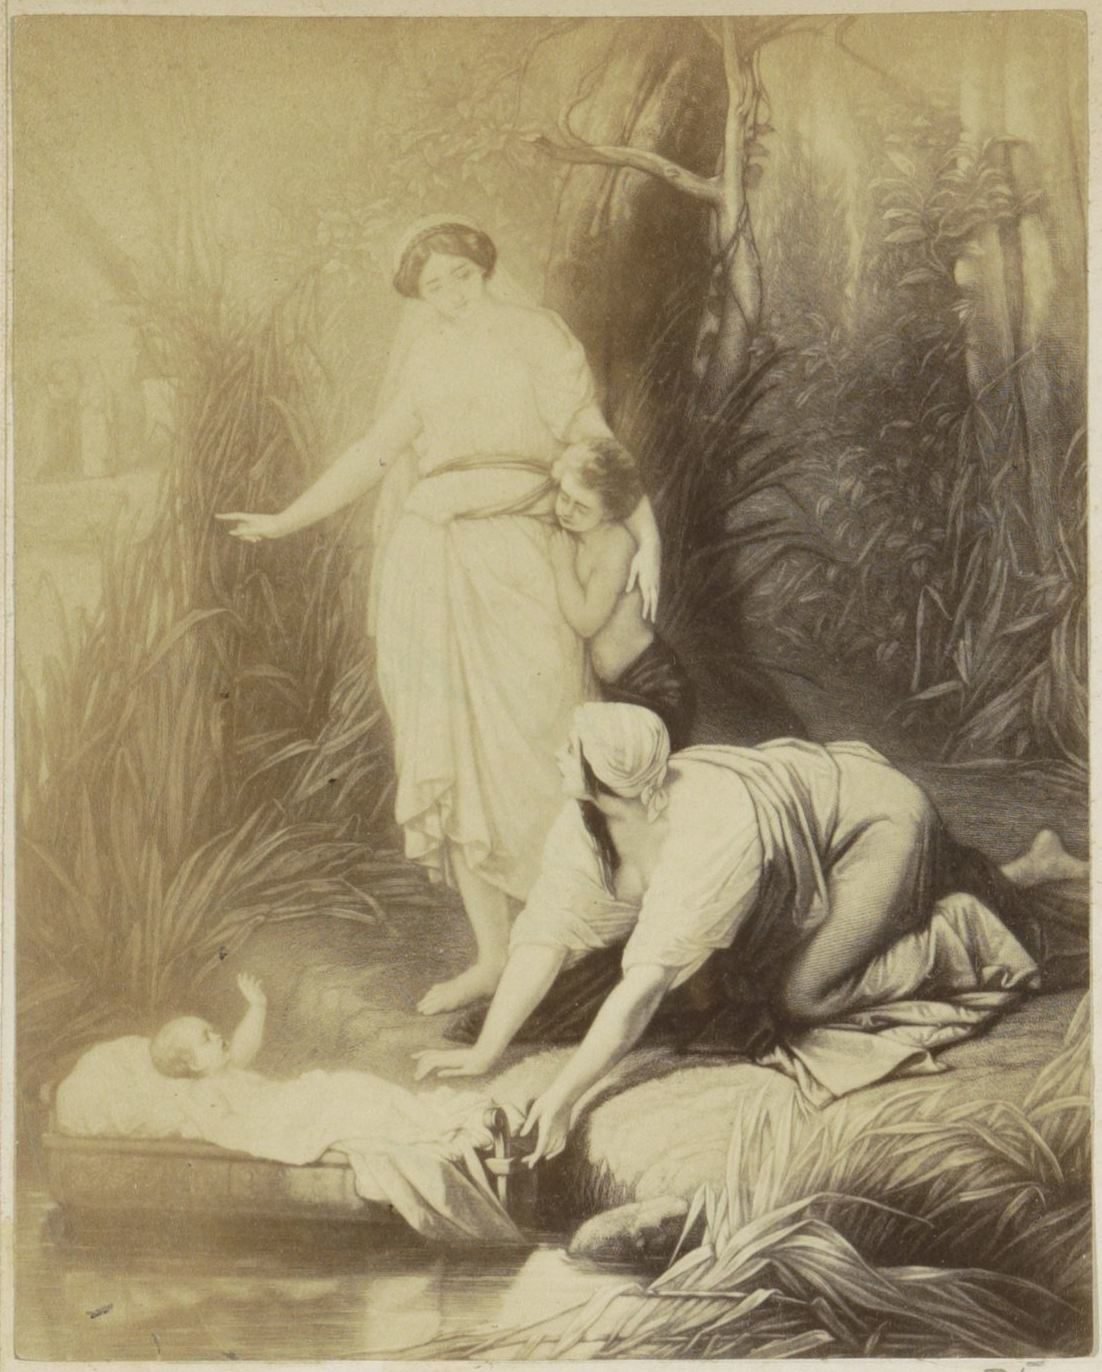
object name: photograph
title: Fotoreproductie van (vermoedelijk) een prent met Mozes in een mand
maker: Anonymous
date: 1850-1870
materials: paper, photographic support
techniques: albumen print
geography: england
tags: the finding of moses: pharaoh's daughter comes to bathe with her maidens in the river and discovers the child floating on the water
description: Onderdeel van Album met foto's van bezienswaardigheden en landschappen in Engeland en van kunst.